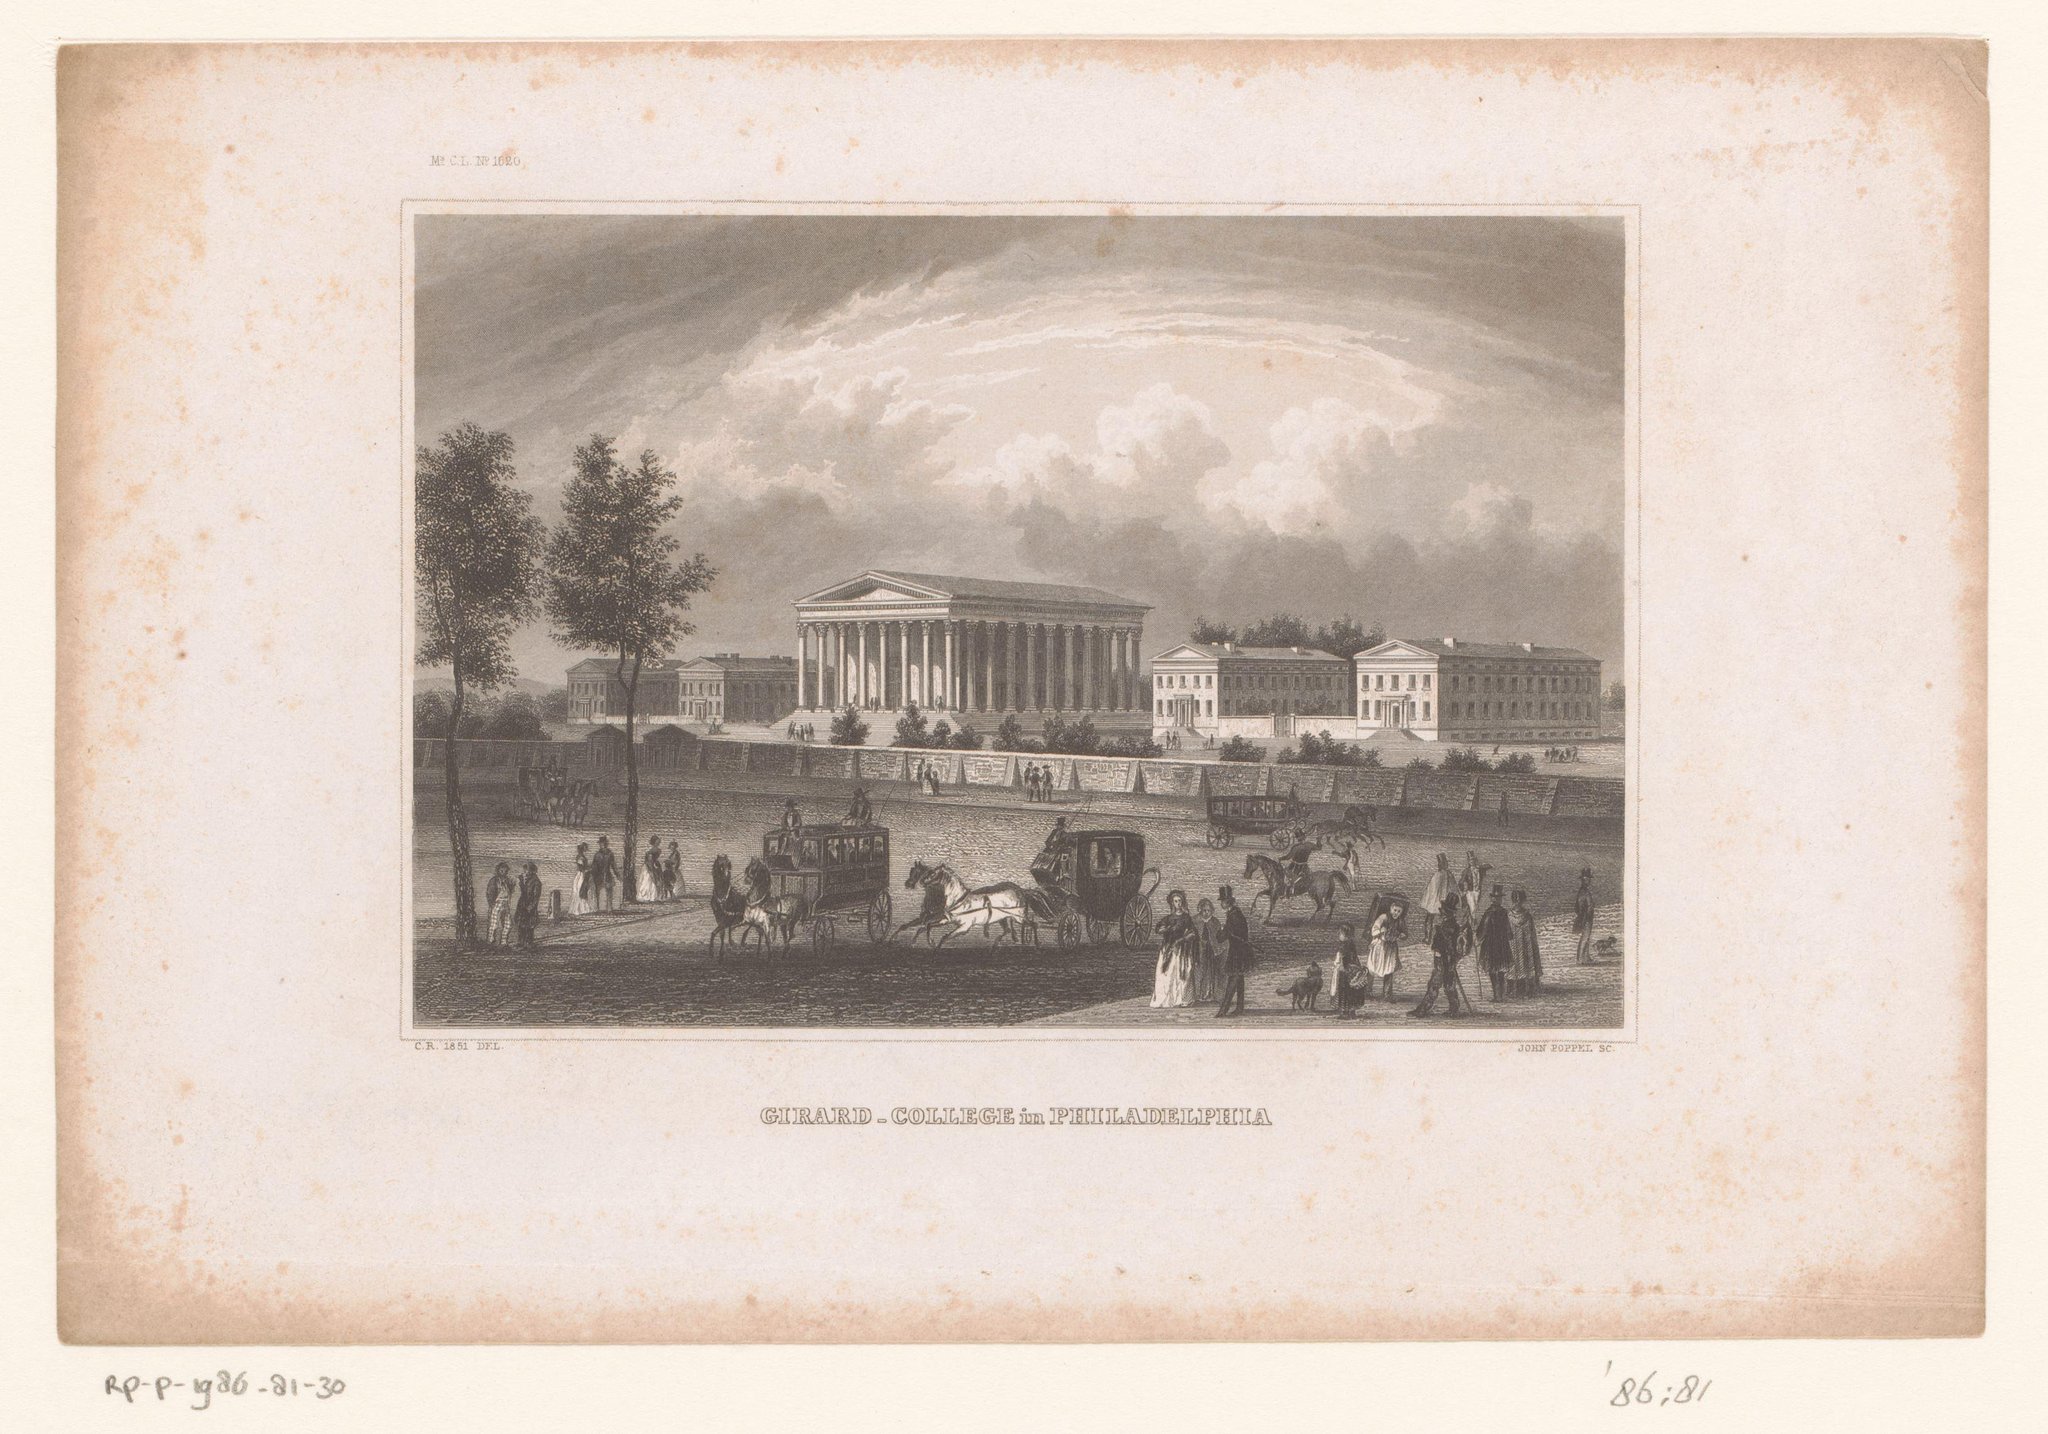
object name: print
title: Gezicht op het Girard-College in Philadelphia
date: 1851-1863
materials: paper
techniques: engraving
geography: hildburghausen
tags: city-view, and landscape with man-made constructions, university building, college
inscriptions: monogram: ‘C.R. 1851 del.’, collector's mark: Lugt 2760, collector's mark: Lugt 2228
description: Prent verschenen in: Meyer, Joseph. Meyer's Universum. Hildburghausen: Bibliographisches Institut, 1835-1863.